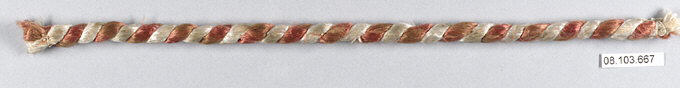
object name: cord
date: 1701-1900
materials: silk